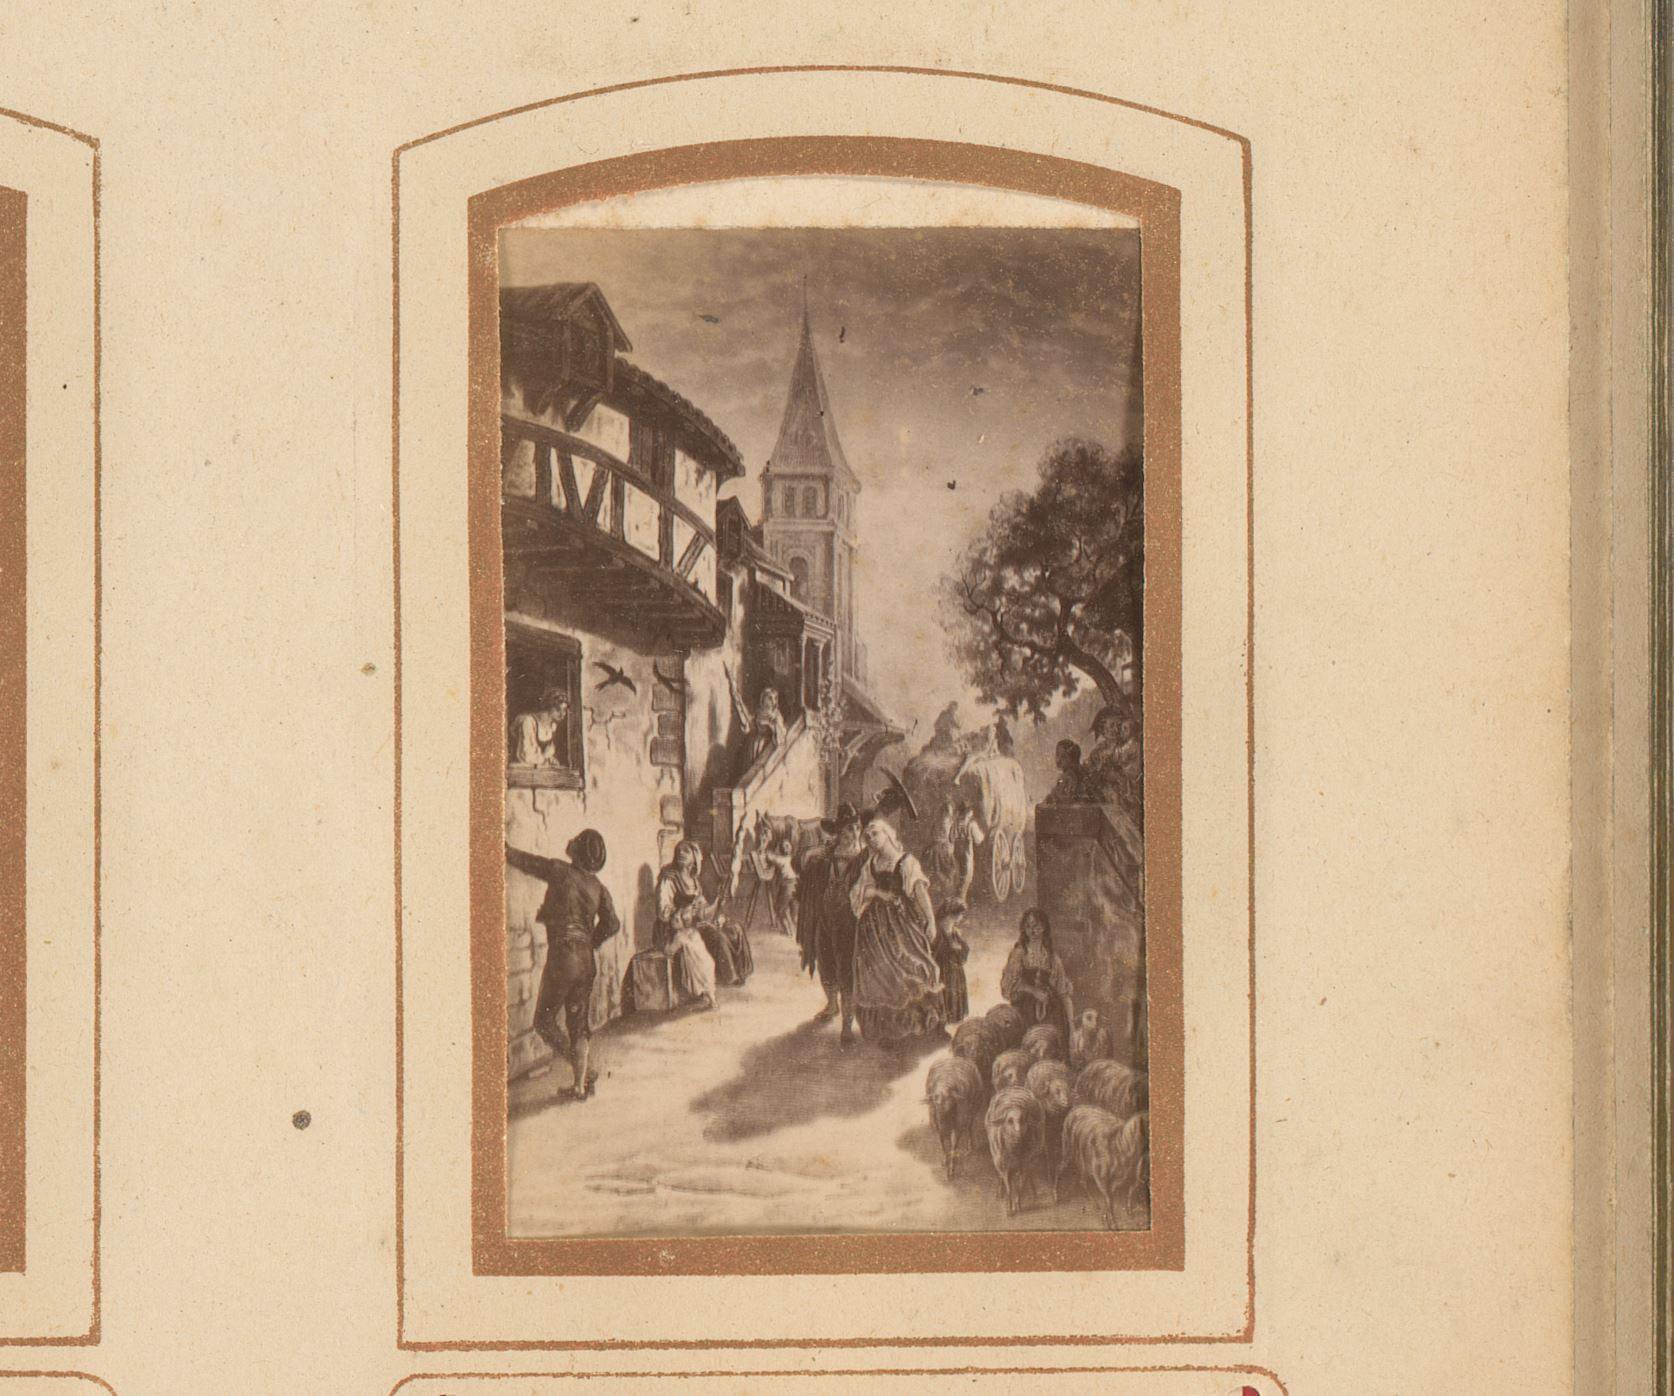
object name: album leaf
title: Fotoreproductie van La Paix door Gustav Doré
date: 1850-1900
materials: cardboard, photographic support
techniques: albumen print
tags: prospect of village, silhouette of village, symbols, allegories of peace, 'pax'; 'pace' (ripa)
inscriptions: annotation: ‘DORÉ: LA PAIX’